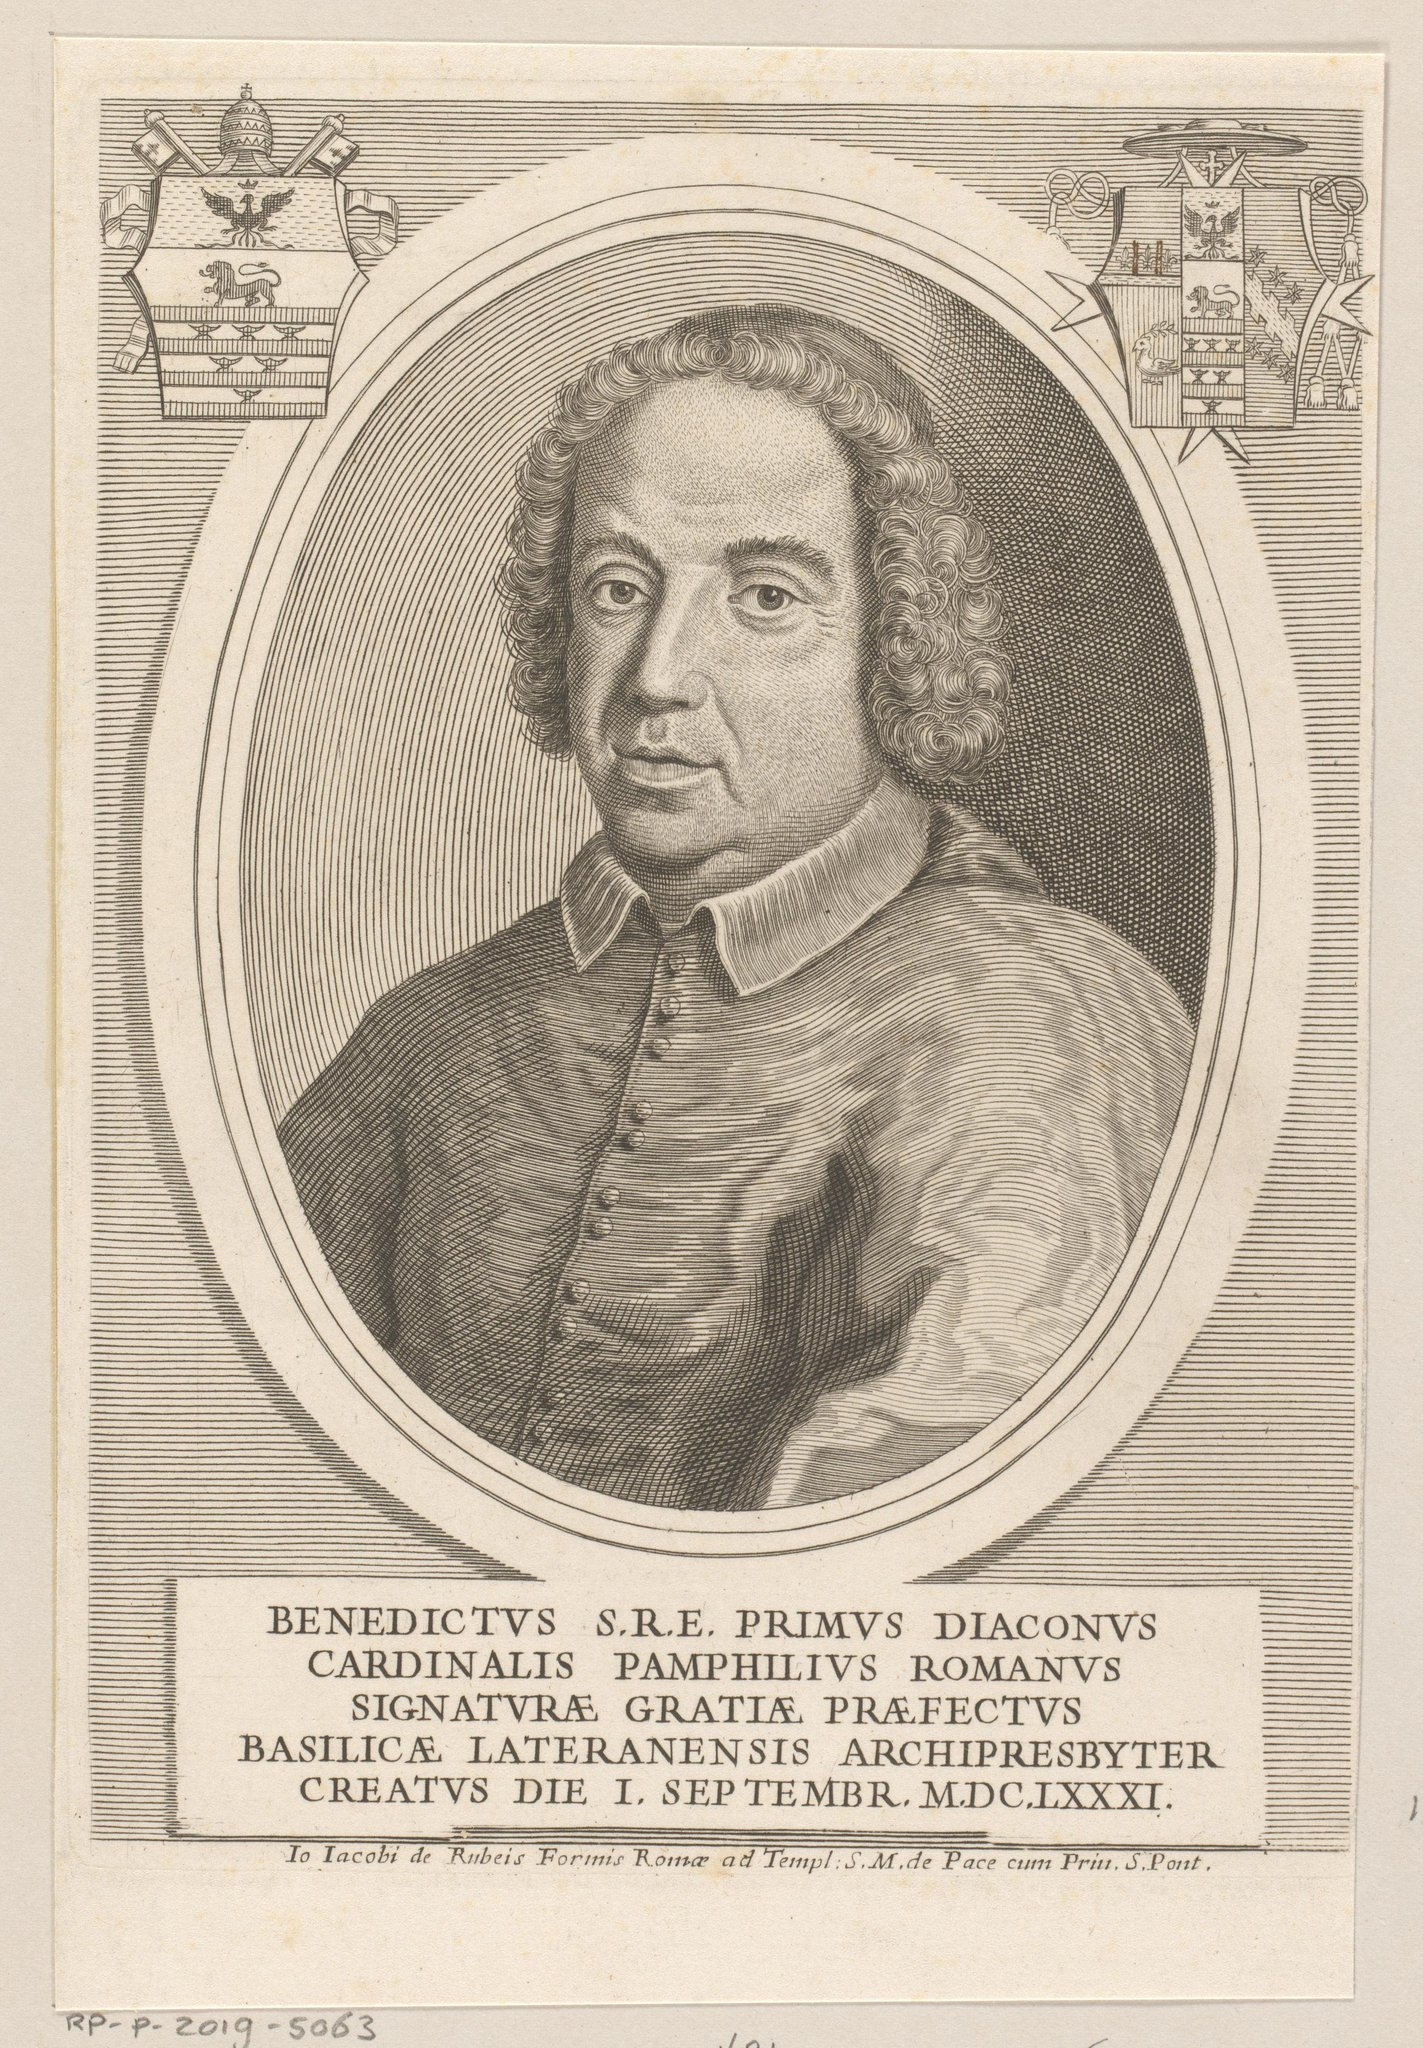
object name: print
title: Portretten van kardinalen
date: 1681-1691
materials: paper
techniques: engraving, etching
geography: rome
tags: rome, benedetto pamphili, cardinal, historical persons, armorial bearing, heraldry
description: Met rechtsboven zijn wapenschild en linksboven het wapen van paus Innocentius XI.